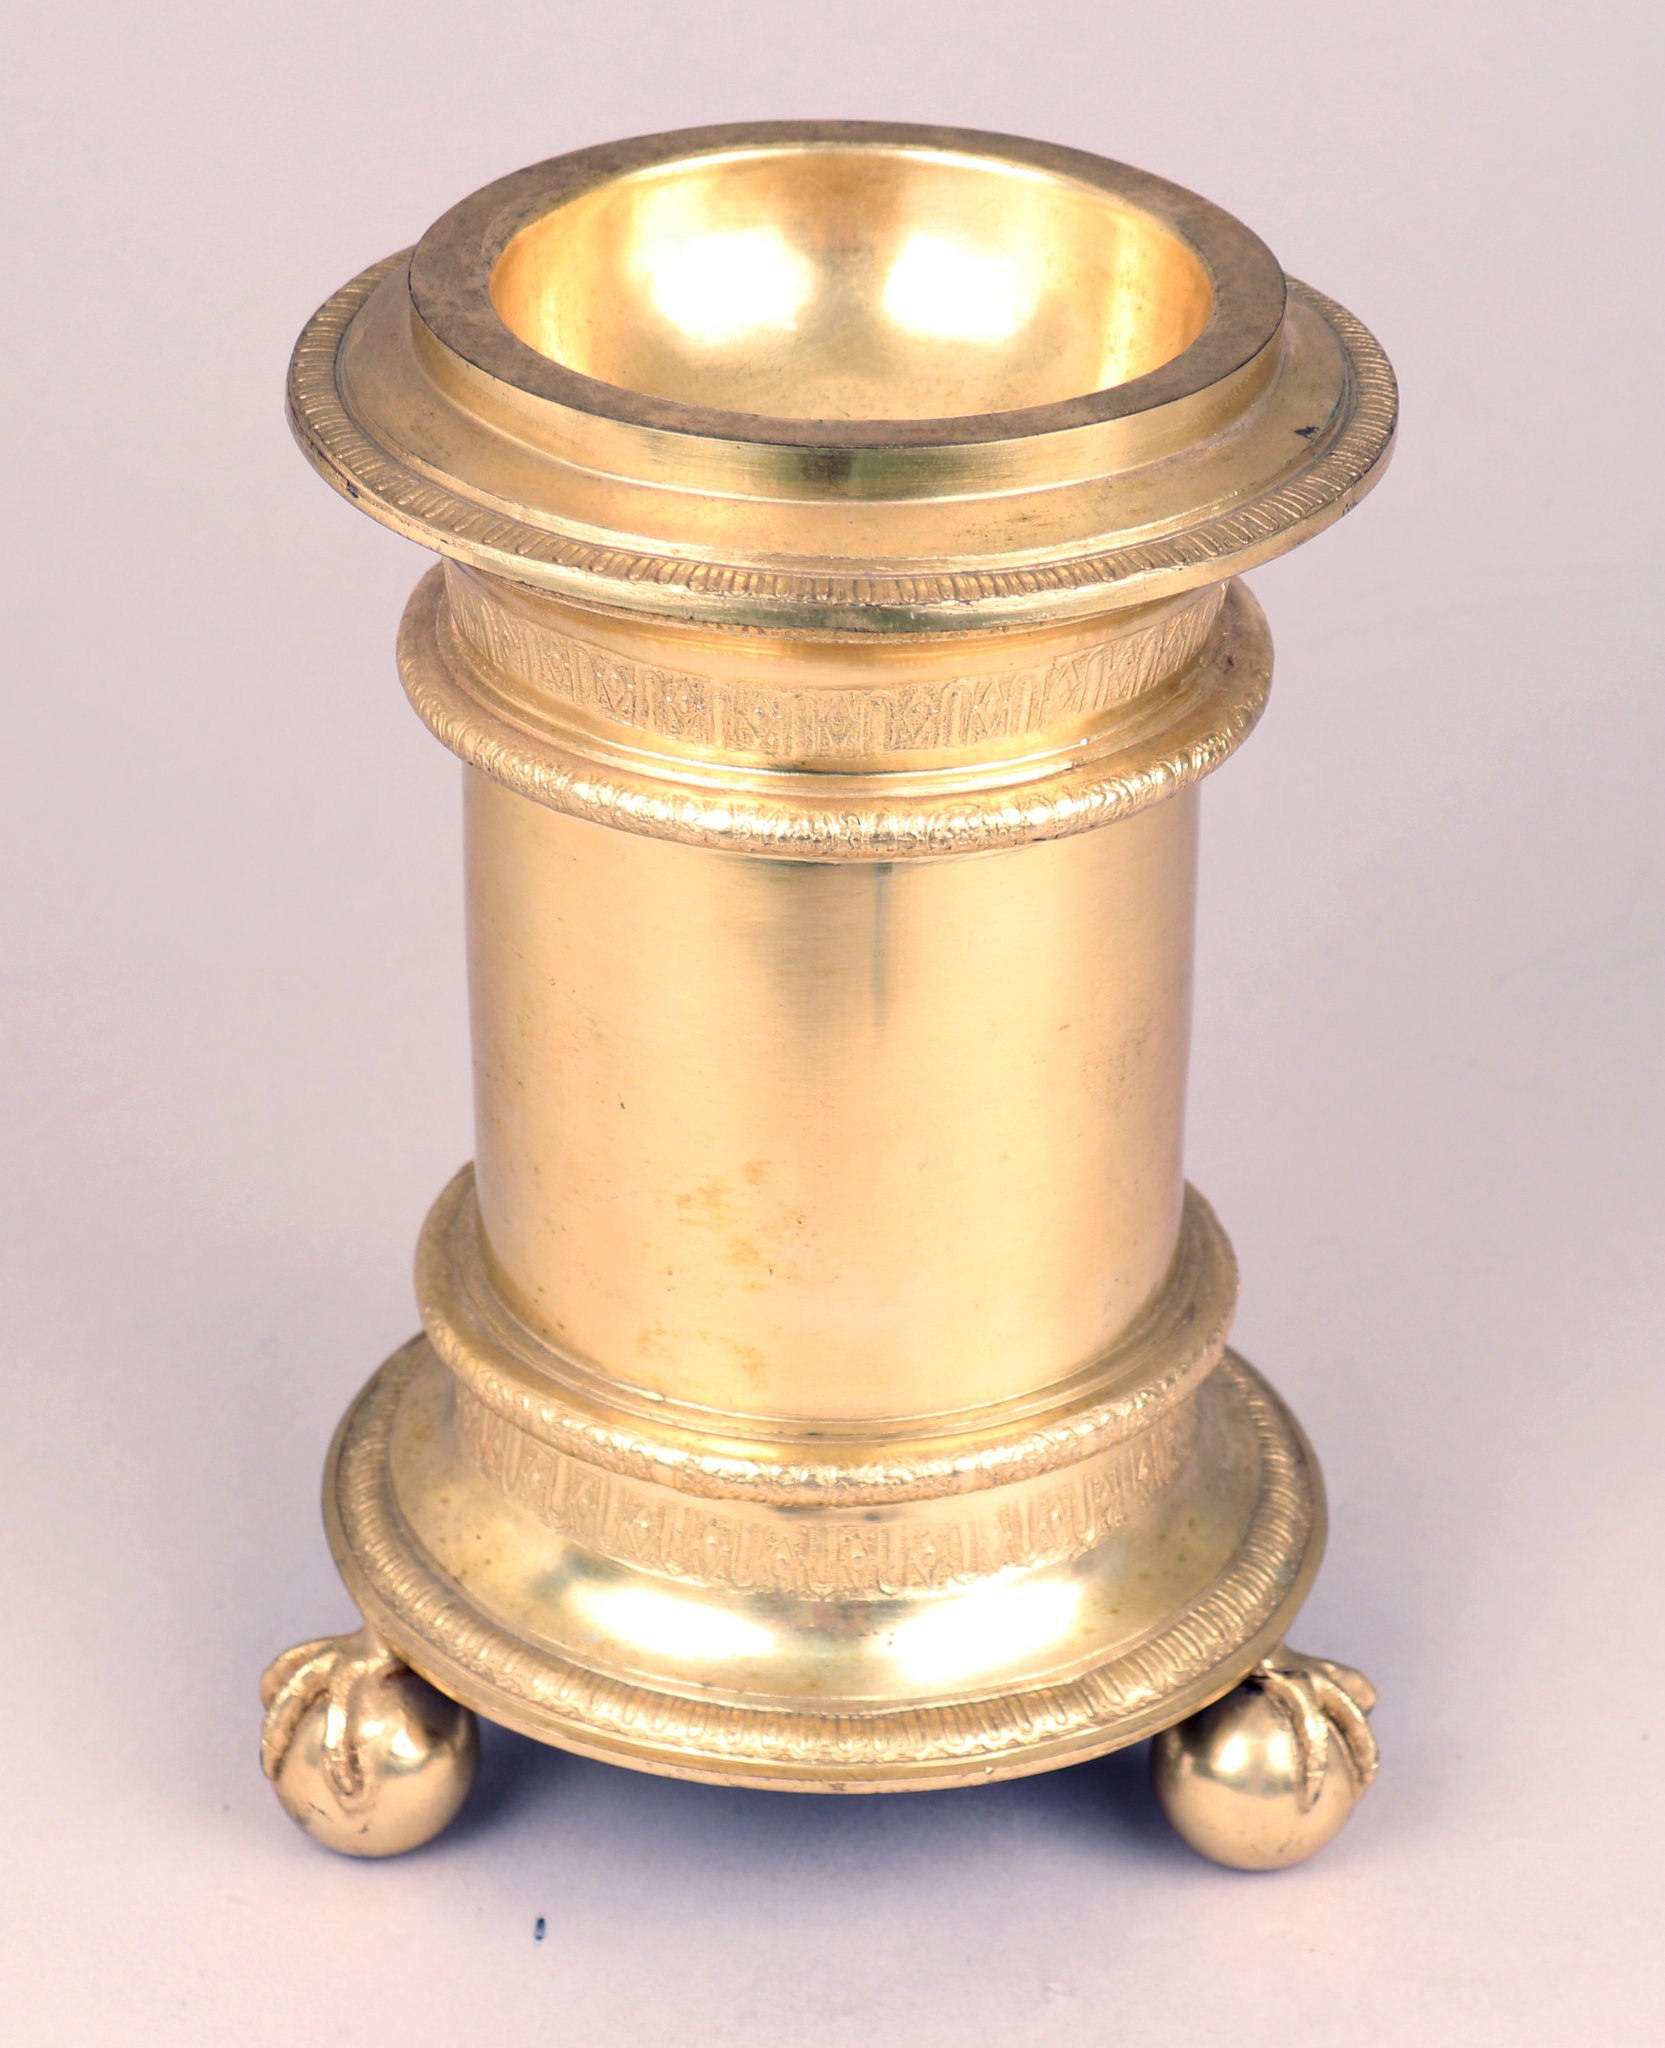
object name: salt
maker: elkington & co.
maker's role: manufacturer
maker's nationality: british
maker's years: 1829-1963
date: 1801-1900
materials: metal, silver